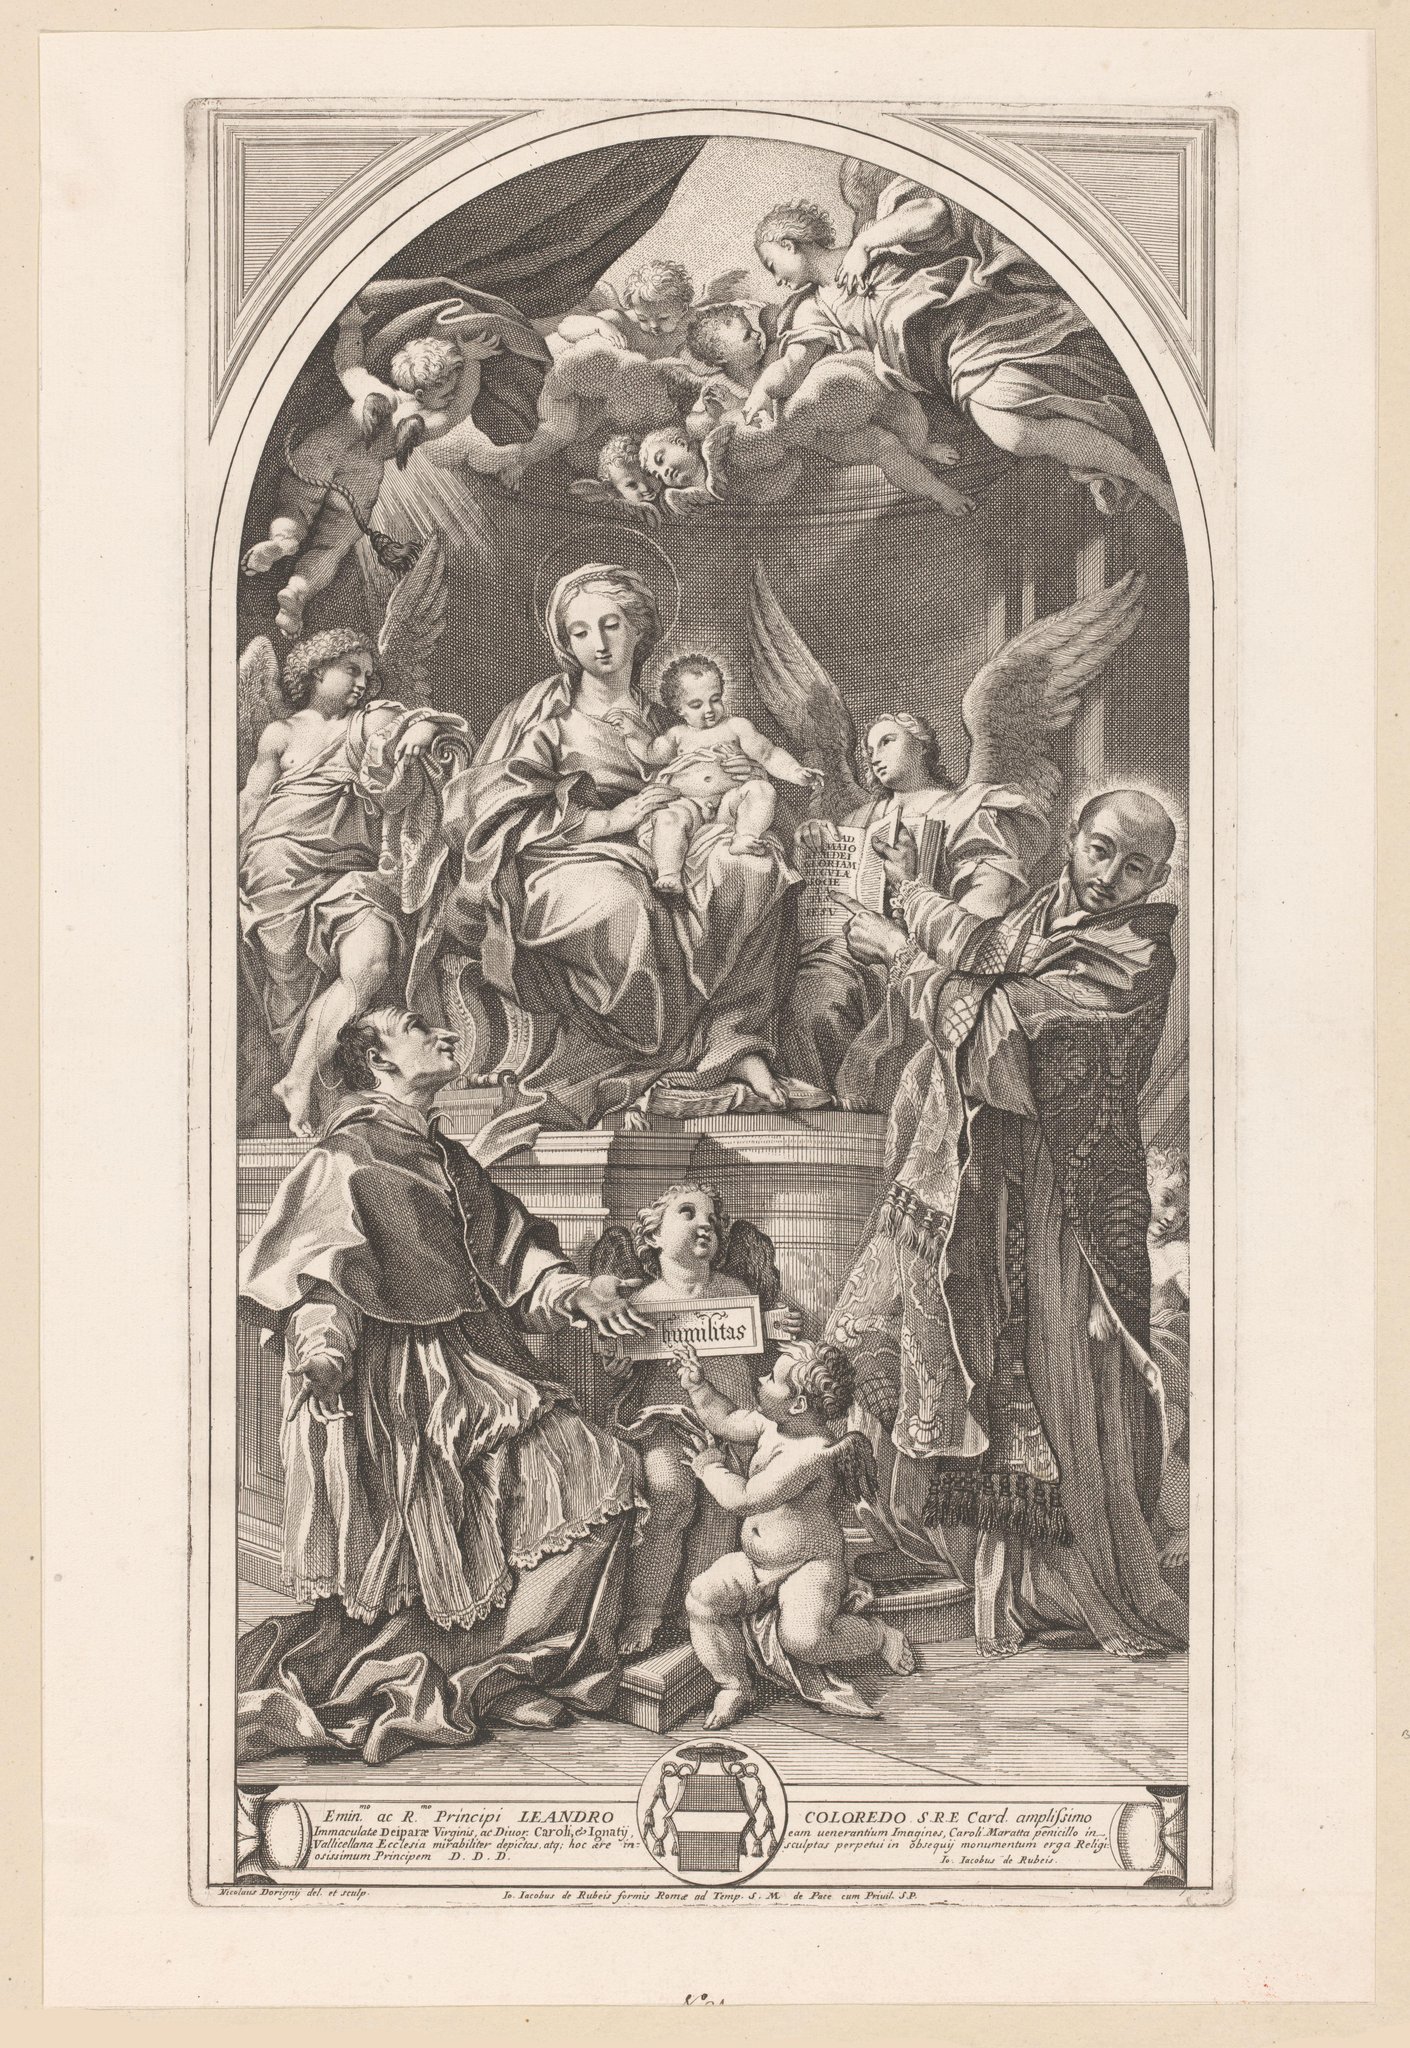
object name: print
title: Verering van Maria en Kind door Carolus Borromeus en Ignatius van Loyola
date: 1662-1746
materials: paper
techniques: engraving, etching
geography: paris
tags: mary sitting or enthroned, the christ-child on her knee (christ-child to mary's left) - ff - the christ-child to mary's right, charles borromeo, cardinal of milan; possible attributes: cardinal's hat, crucifix, rope round his neck, skull, the founder of the jesuit order, ignatius of loyola; possible attributes: book (with 'ad majorem dei gloriam'), demon, dragon under feet, flames, flaming heart, globe, ihs monogram, skull (with crown), tears in eyes, torch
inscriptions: collector's mark: Lugt 240